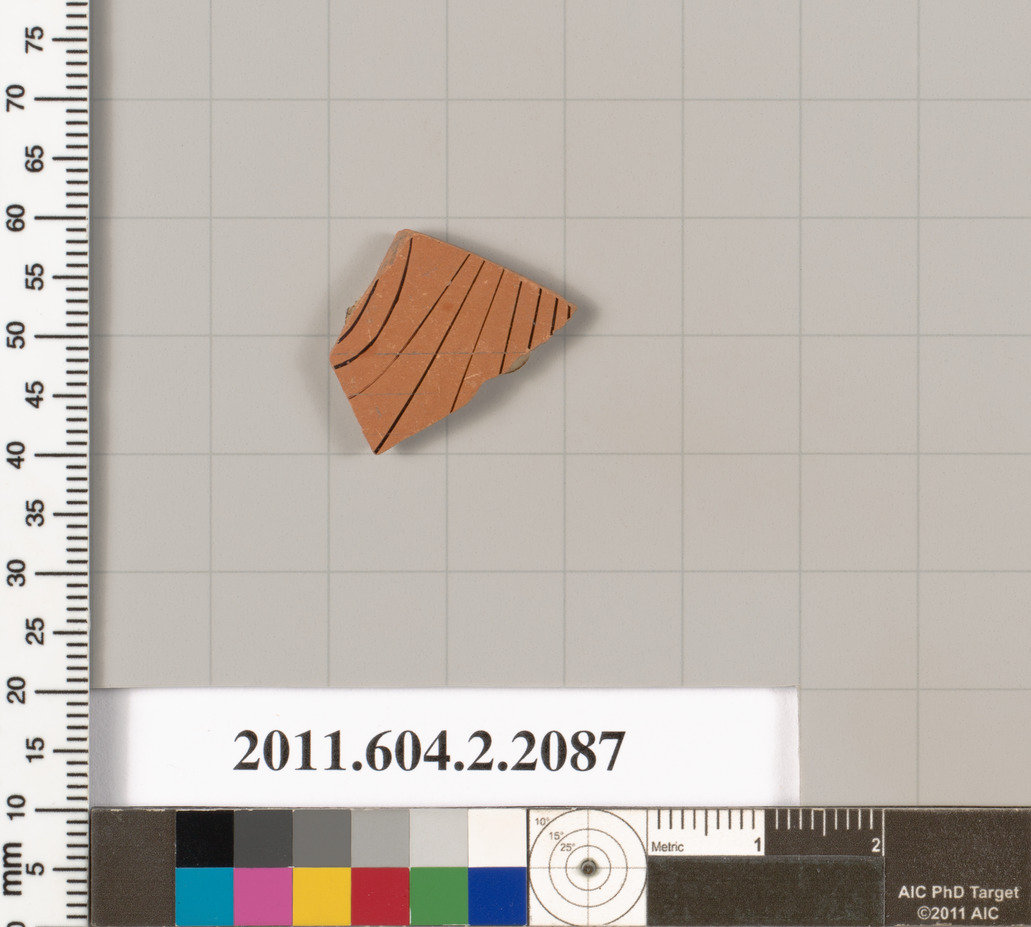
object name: pot fragment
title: Terracotta fragment of a pot; glazed on the inside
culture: greek, attic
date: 475-451 BCE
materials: terracotta